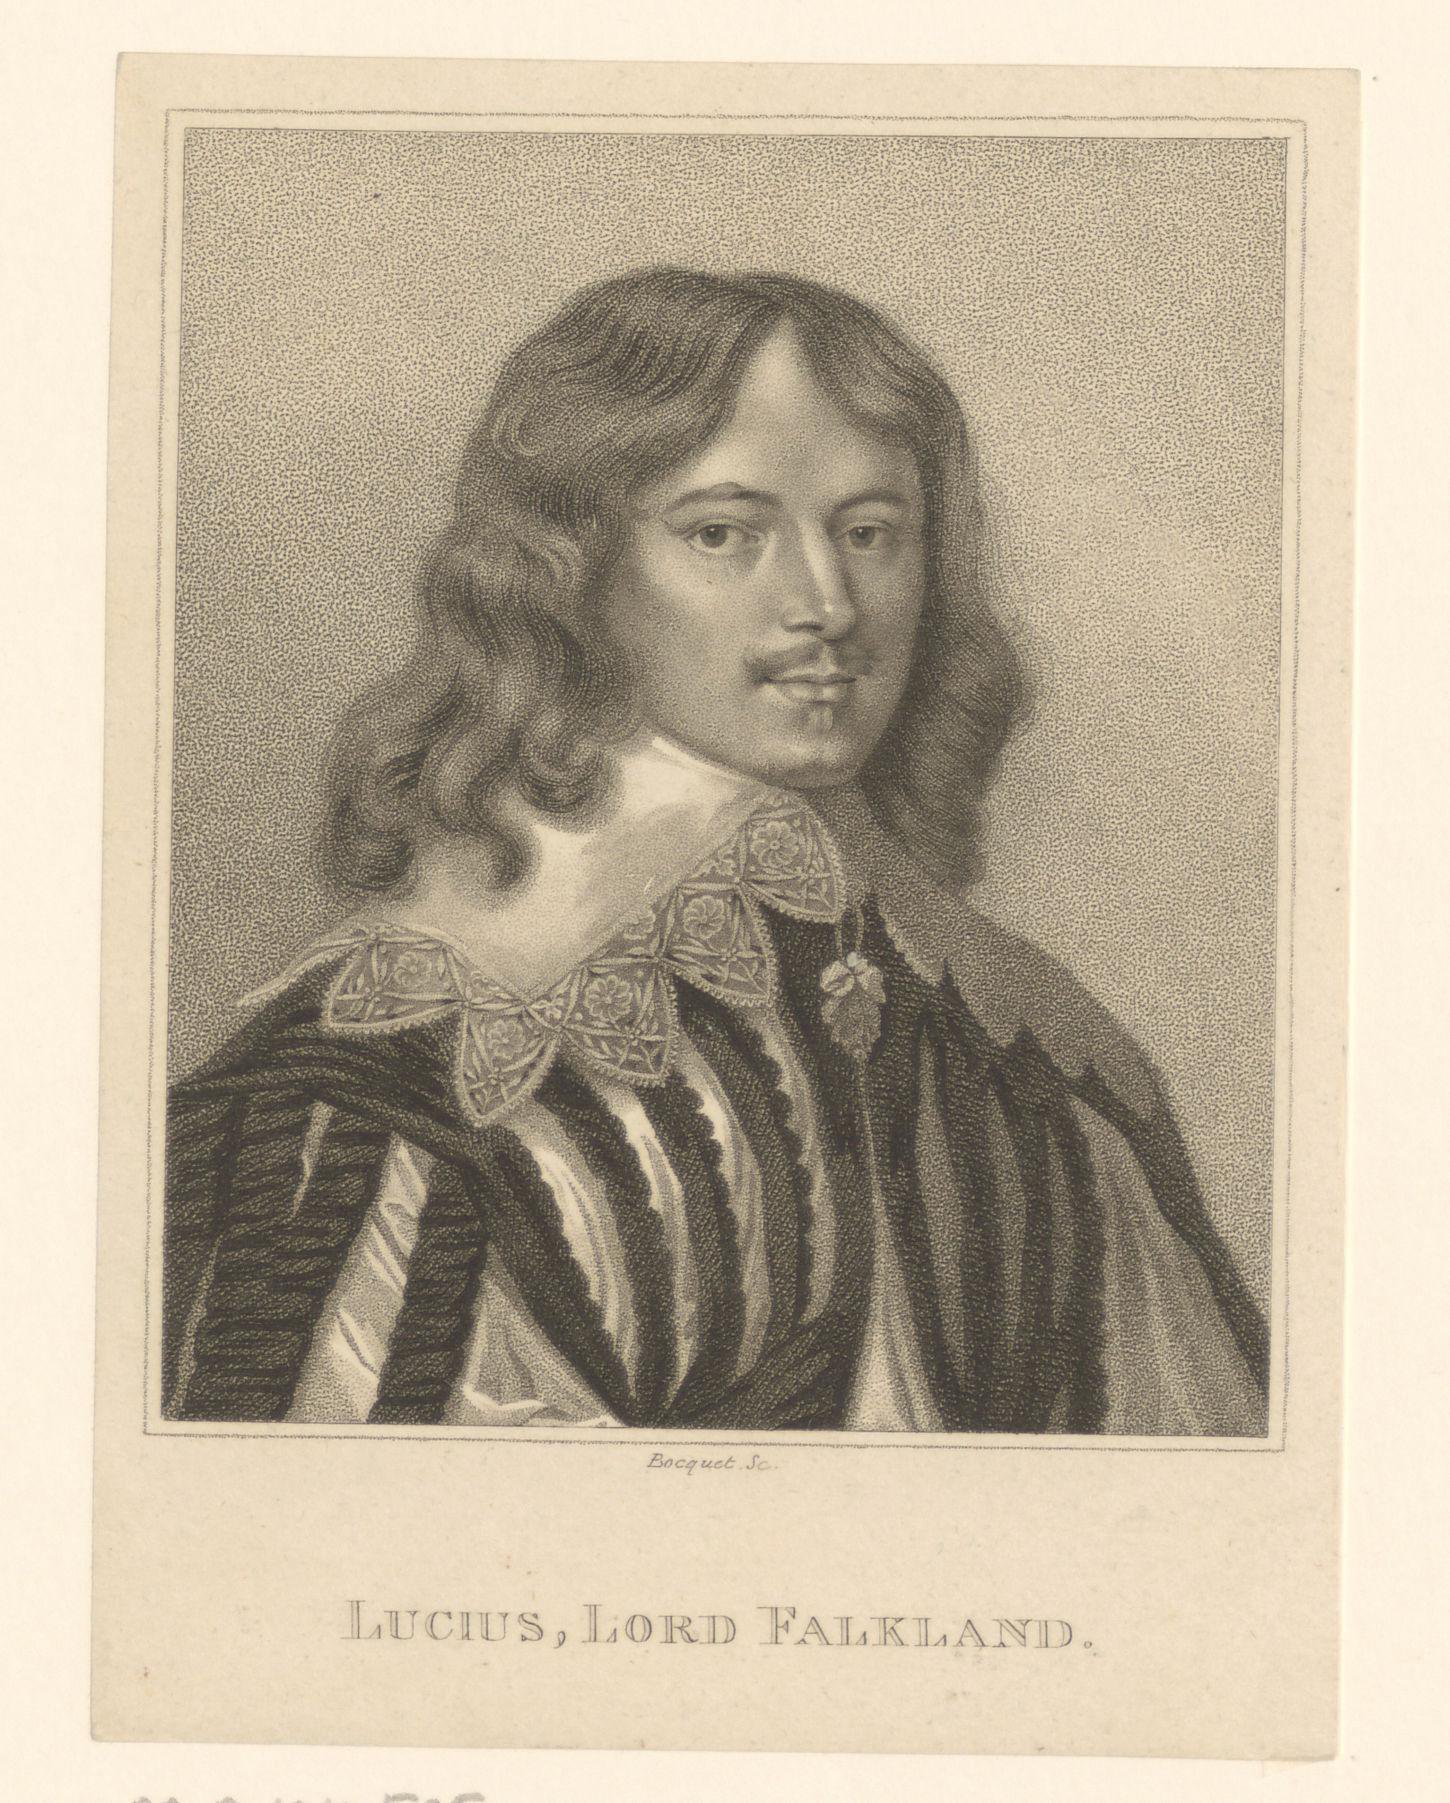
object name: print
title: Lucius, Lord Falkland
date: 1806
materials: paper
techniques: engraving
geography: england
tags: politician, historical persons, politician, e.g. party leader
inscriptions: collector's mark: Lugt 2228